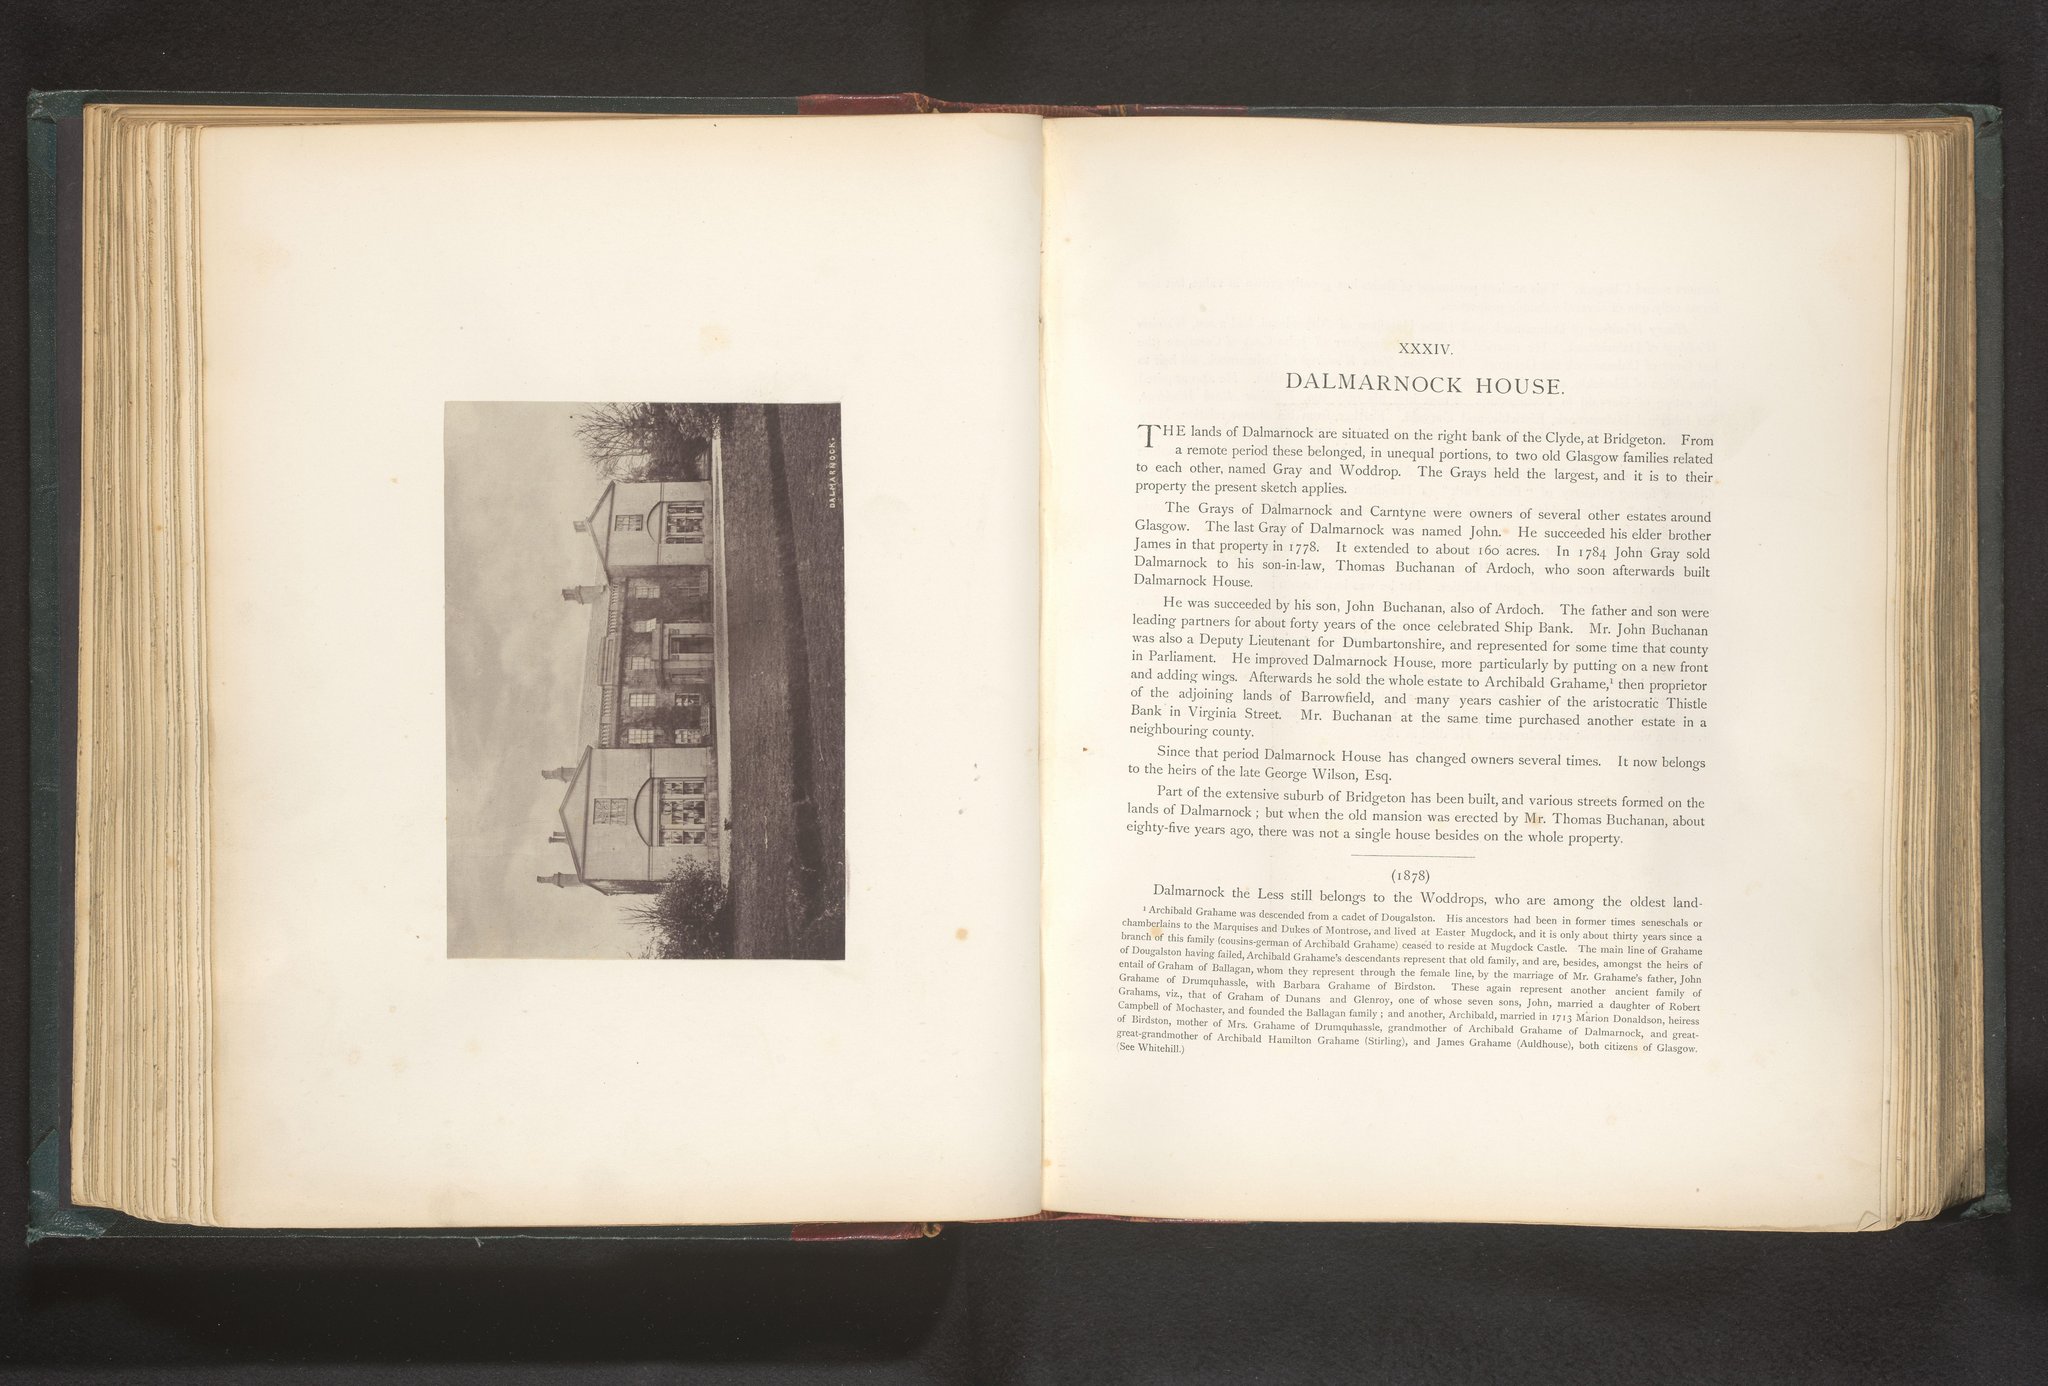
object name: page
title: Dalmarnock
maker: thomas annan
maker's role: fotograaf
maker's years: 1829-1887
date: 1868-1878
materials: paper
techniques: carbon print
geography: glasgow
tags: rural housing, e.g. country-house, villa, cottage, façade (of house or building)